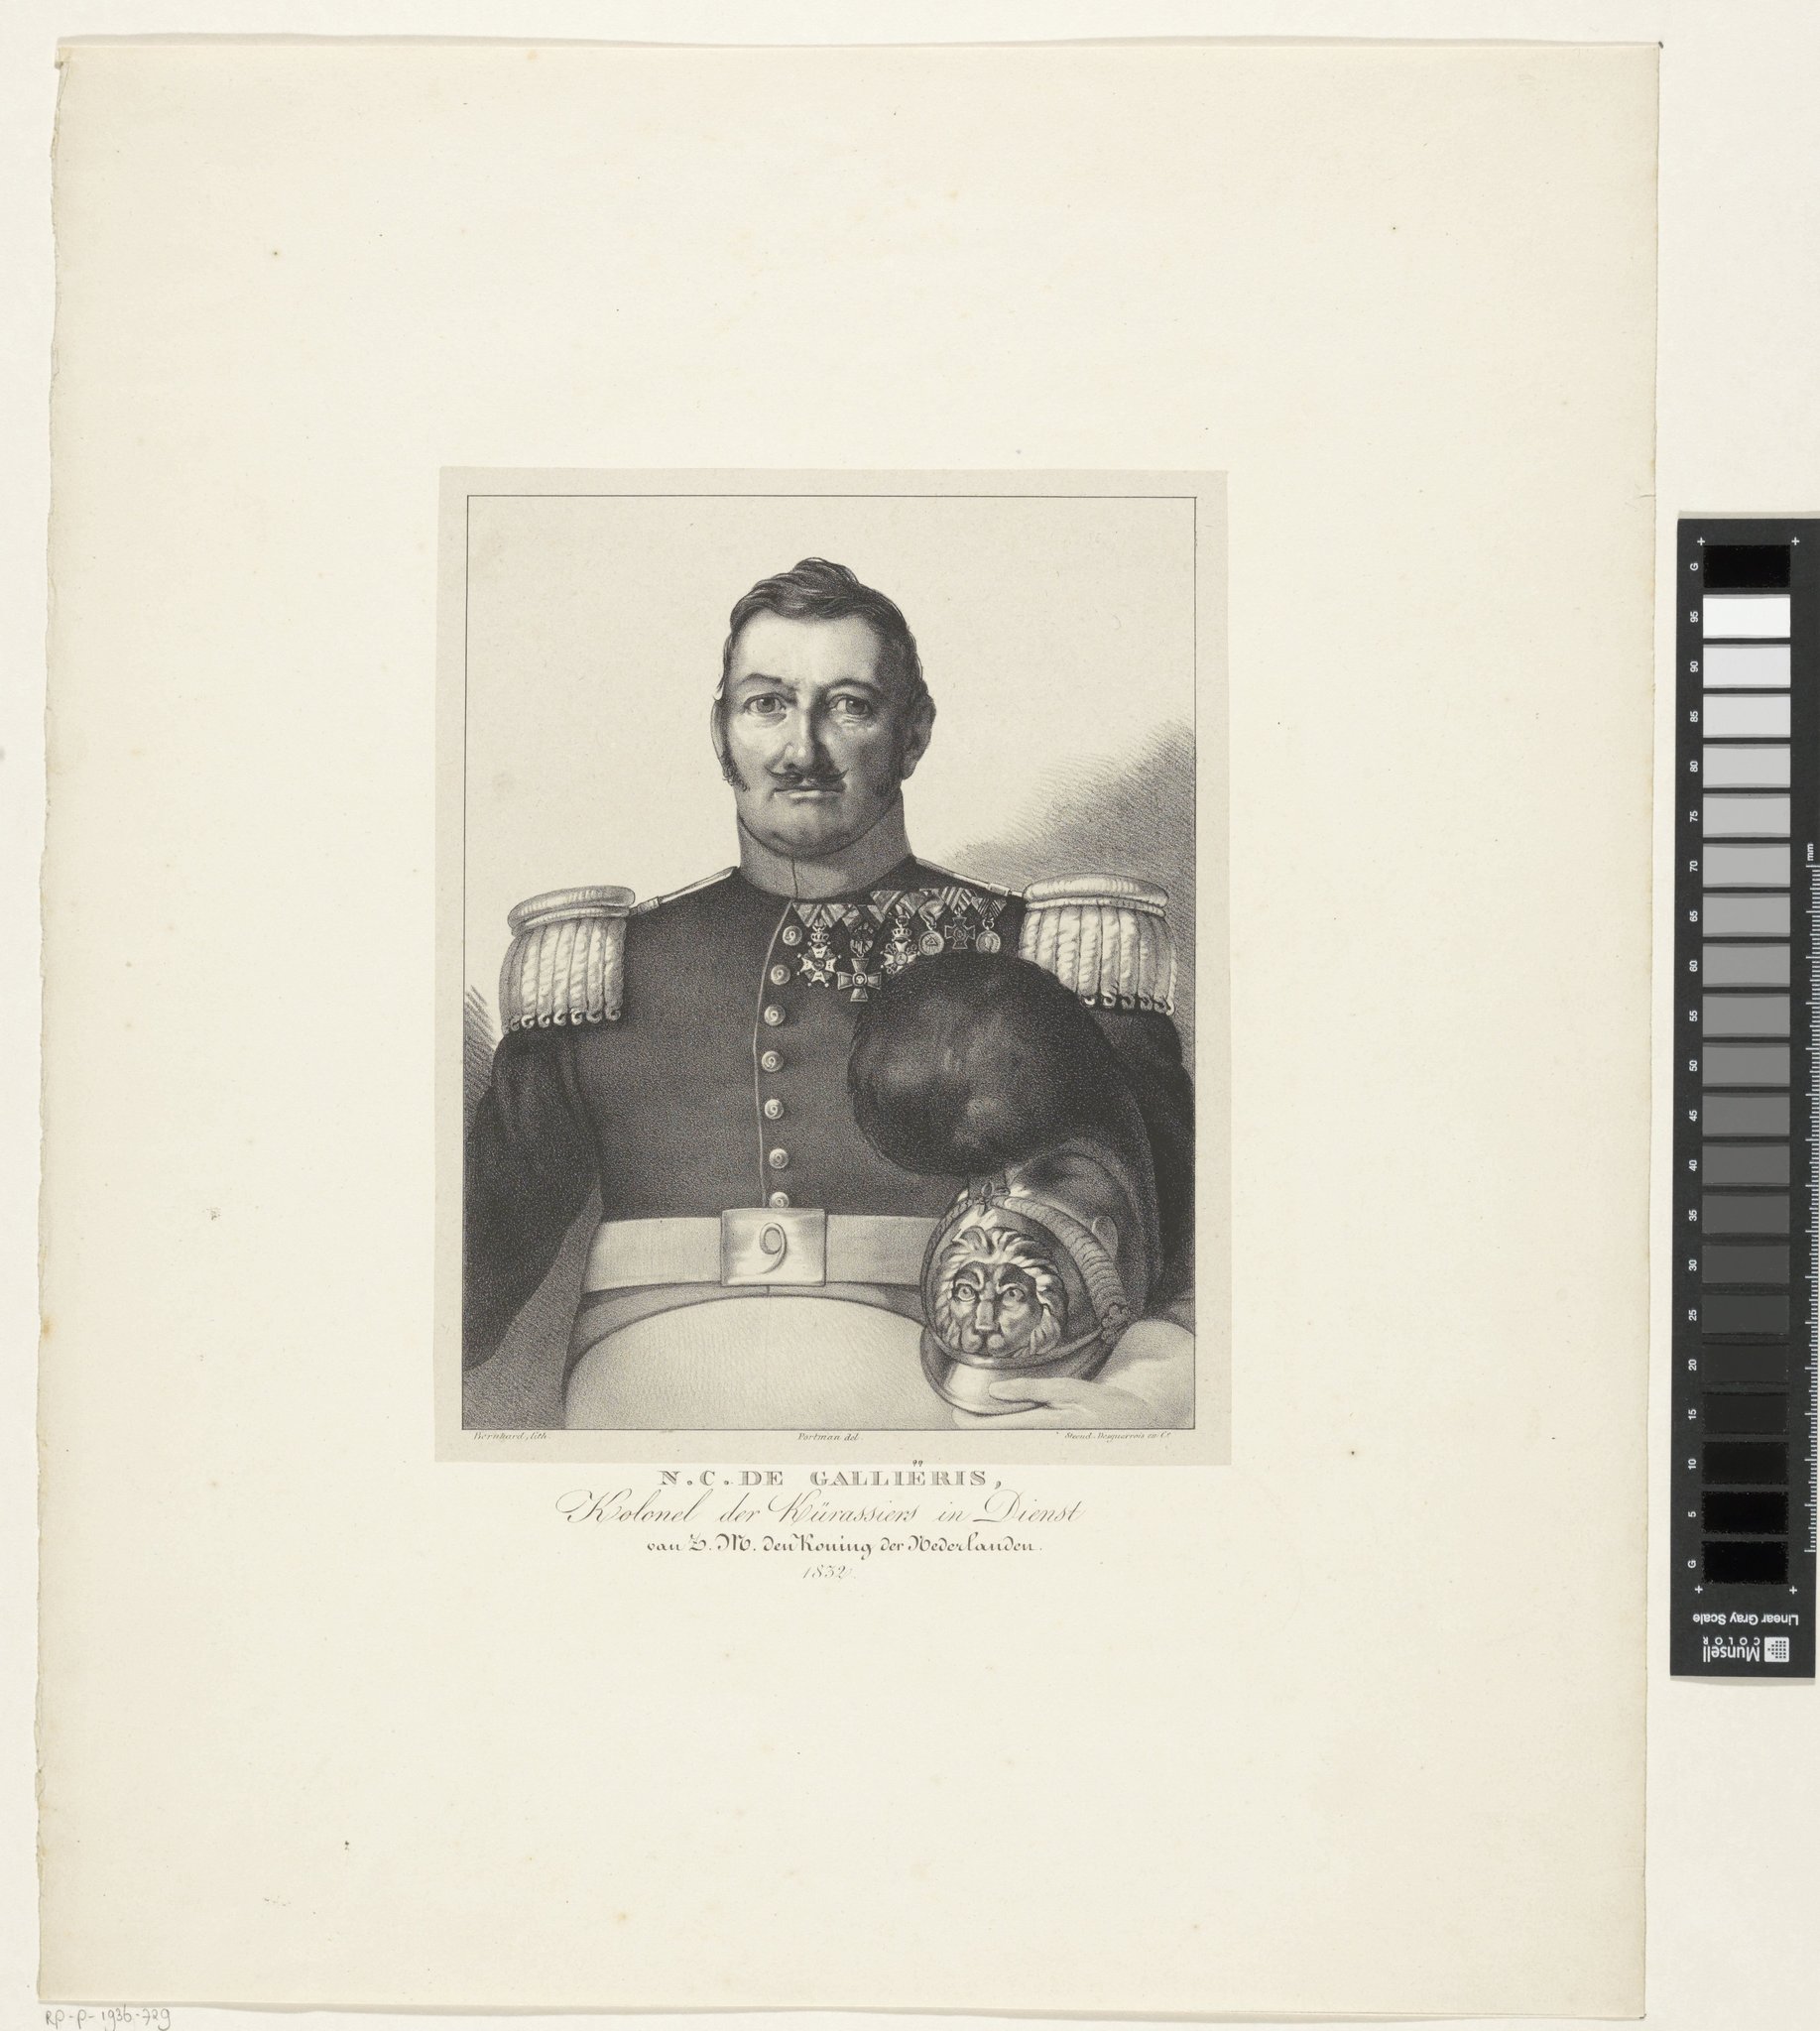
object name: print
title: Portret van kolonel Nicolaas Cornelis de Gallières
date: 1832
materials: paper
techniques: lithograph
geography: the hague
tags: helmet, knighthood order, historical persons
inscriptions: collector's mark: Lugt 2760, collector's mark: Lugt 2228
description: De geportretteerde heeft zijn helm afgenomen en draagt deze in zijn linkerarm. Hij draagt verschillende decoraties op zijn borst. Onder het portret de naam en het beroep van de geportretteerde.